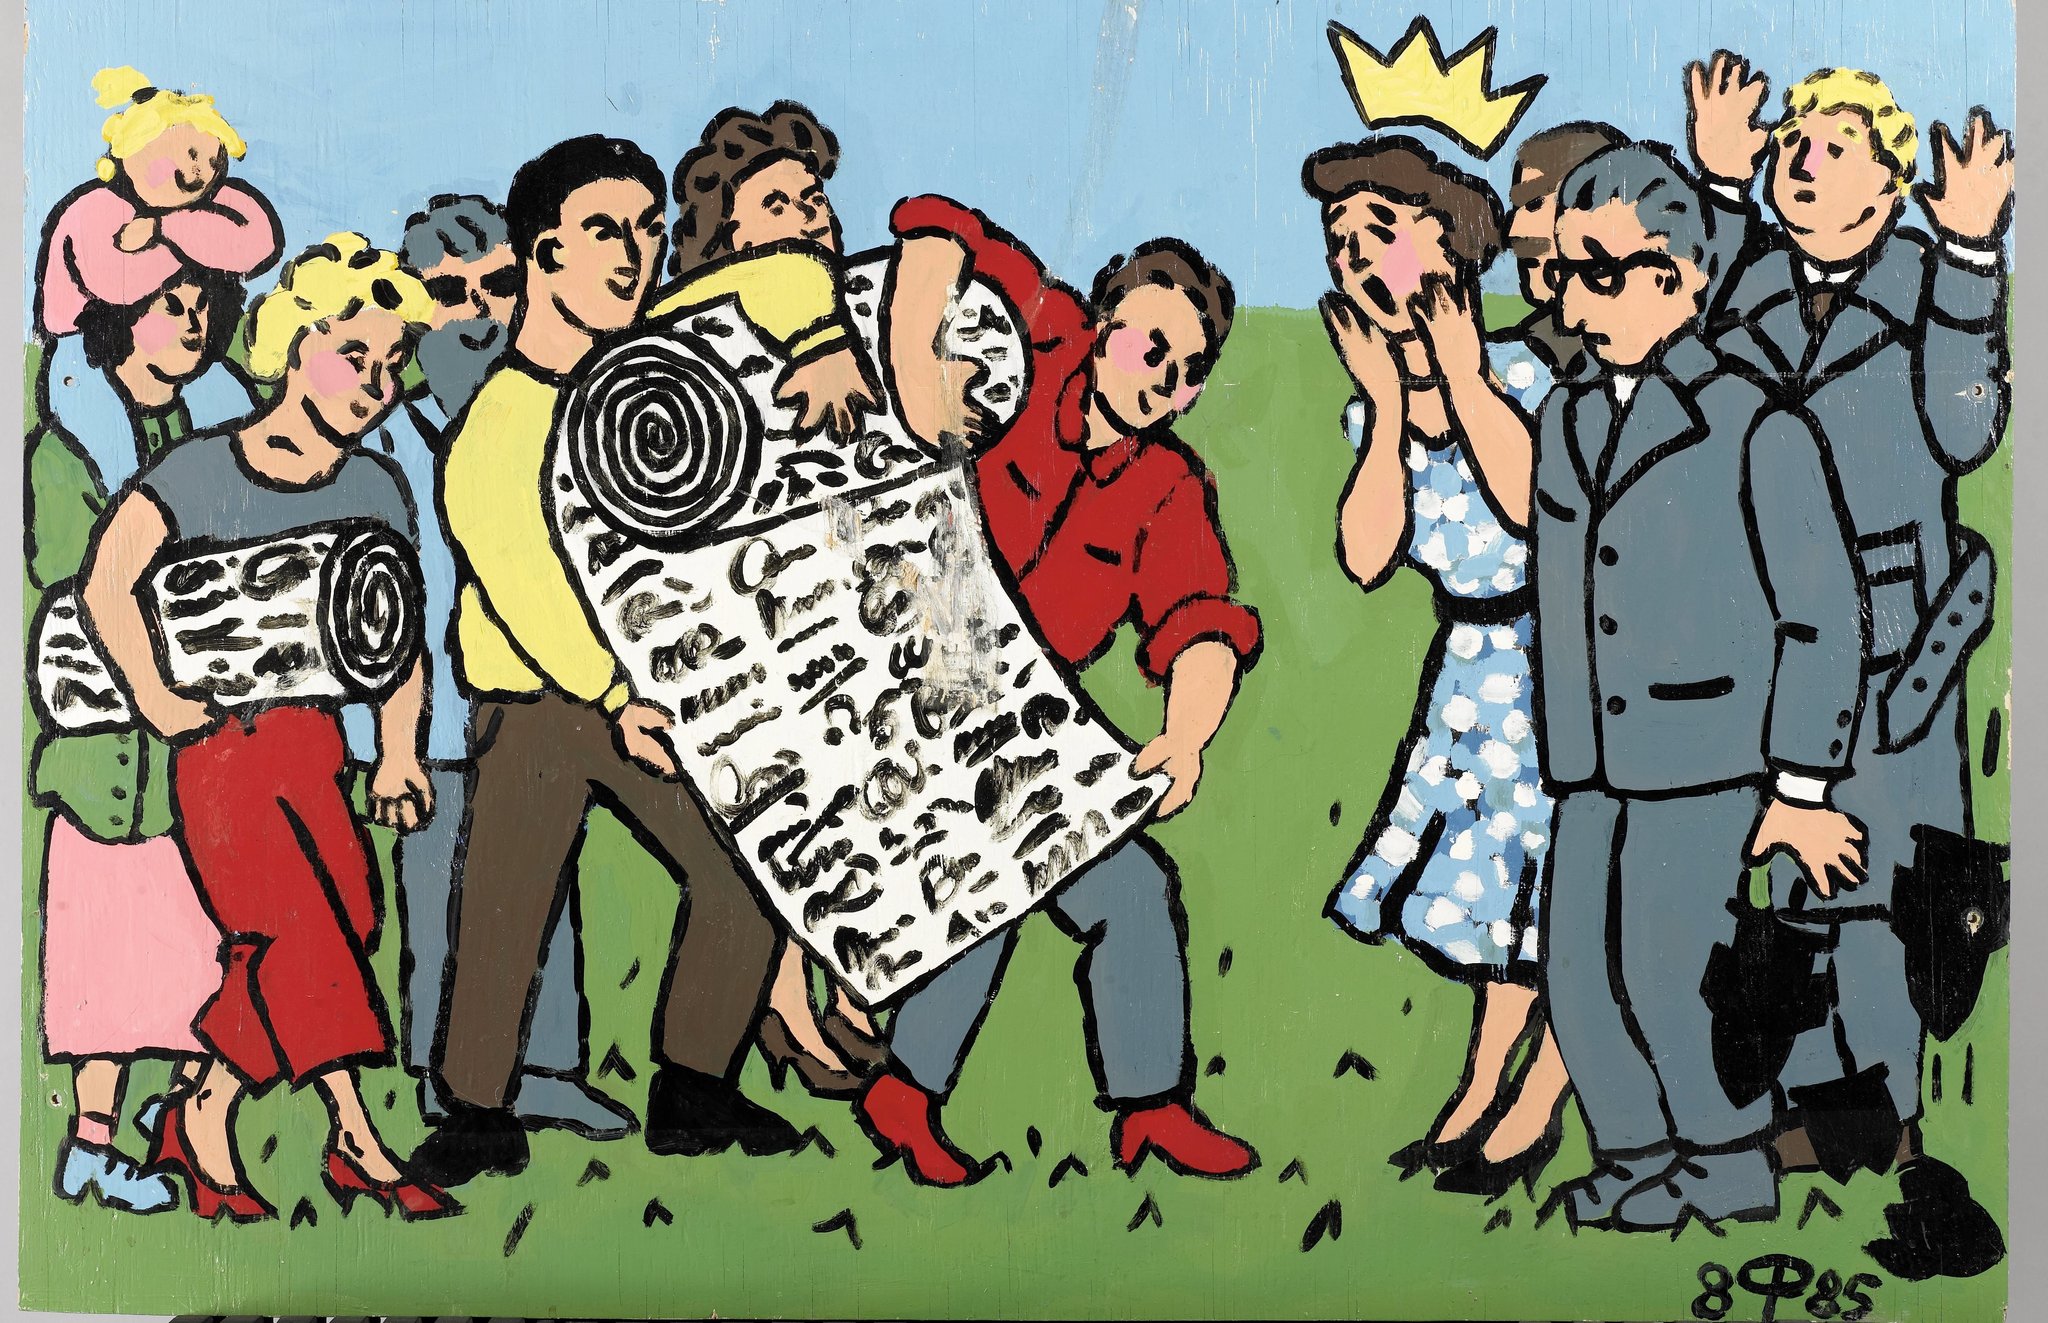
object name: information sign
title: Brugbord betreffende het Volkspetitionnement 1 november 1985.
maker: carolien perdeck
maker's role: artist, painter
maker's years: 1959-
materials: paint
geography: amsterdam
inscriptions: date: ‘8P85’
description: Bord gemaakt voor de aktie tegen kruisraketten, een aktie van het KKN voor het volkspetitionnement 1 november 1985. Menigte (links) biedt lijst met handtekeningen aan aan de regering (rechts). Afbeelding zeer gekleurd.